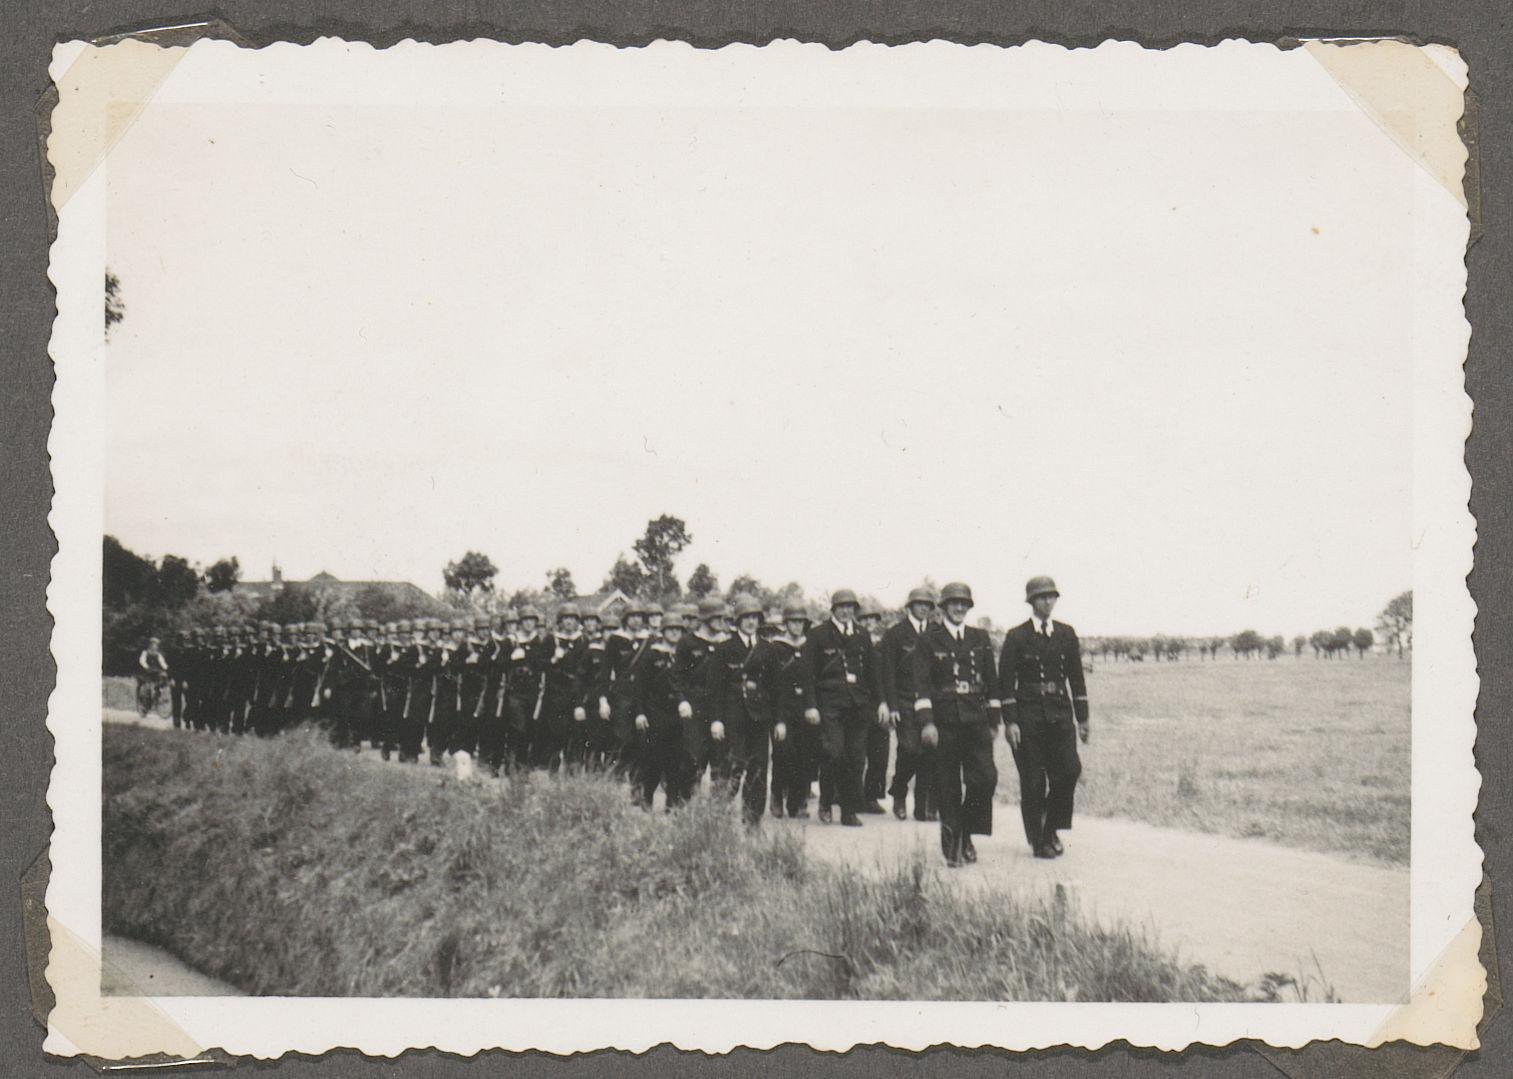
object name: photograph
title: Marcherende militairen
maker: Anonymous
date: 1941-1945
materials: paper, photographic support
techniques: gelatin silver print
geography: netherlands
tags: adult man, historical persons, occupation ~ war, netherlands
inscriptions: annotation: ‘Ausmarch U-Stad aR. Flott’